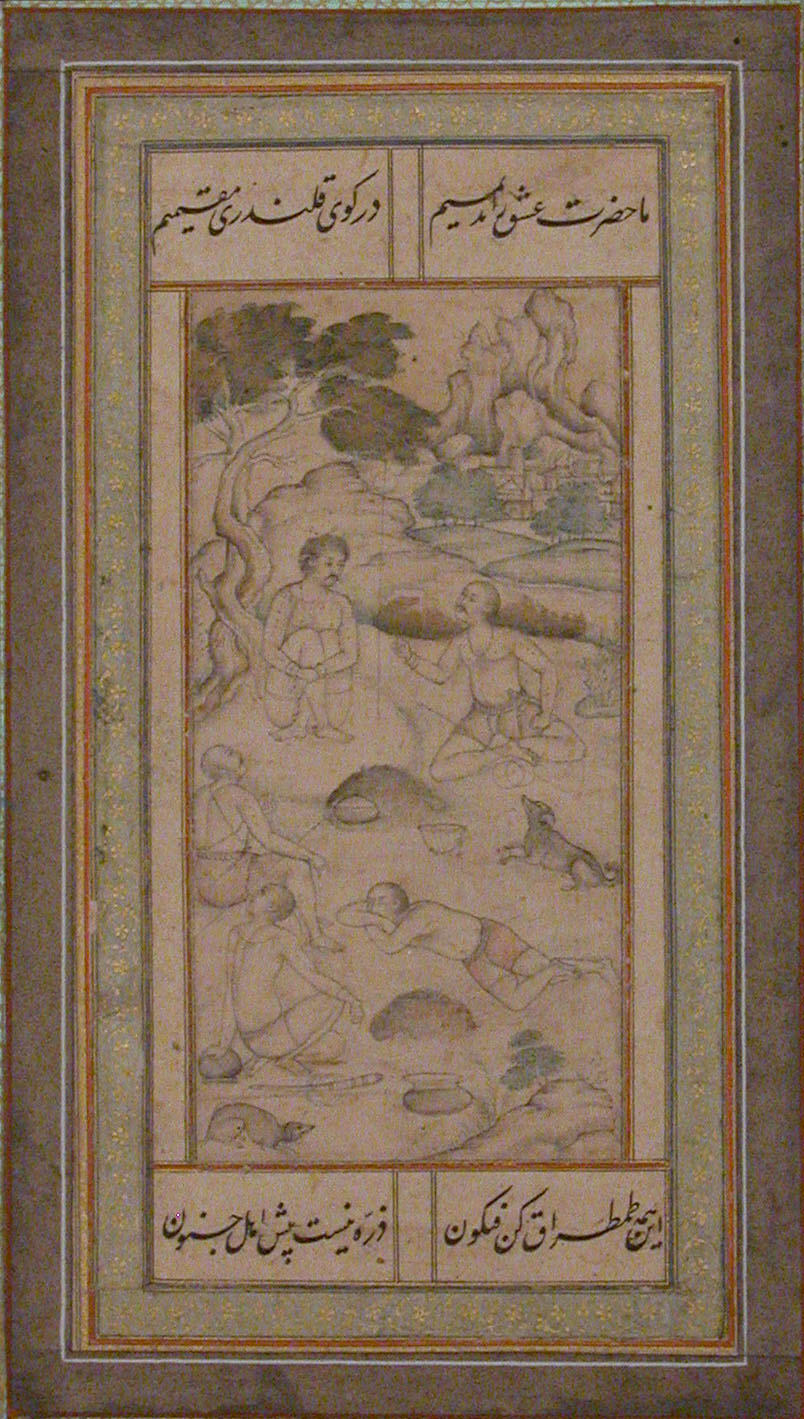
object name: illustrated album leaf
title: Fakirs Resting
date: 1601-1700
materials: silk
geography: india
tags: animals,men